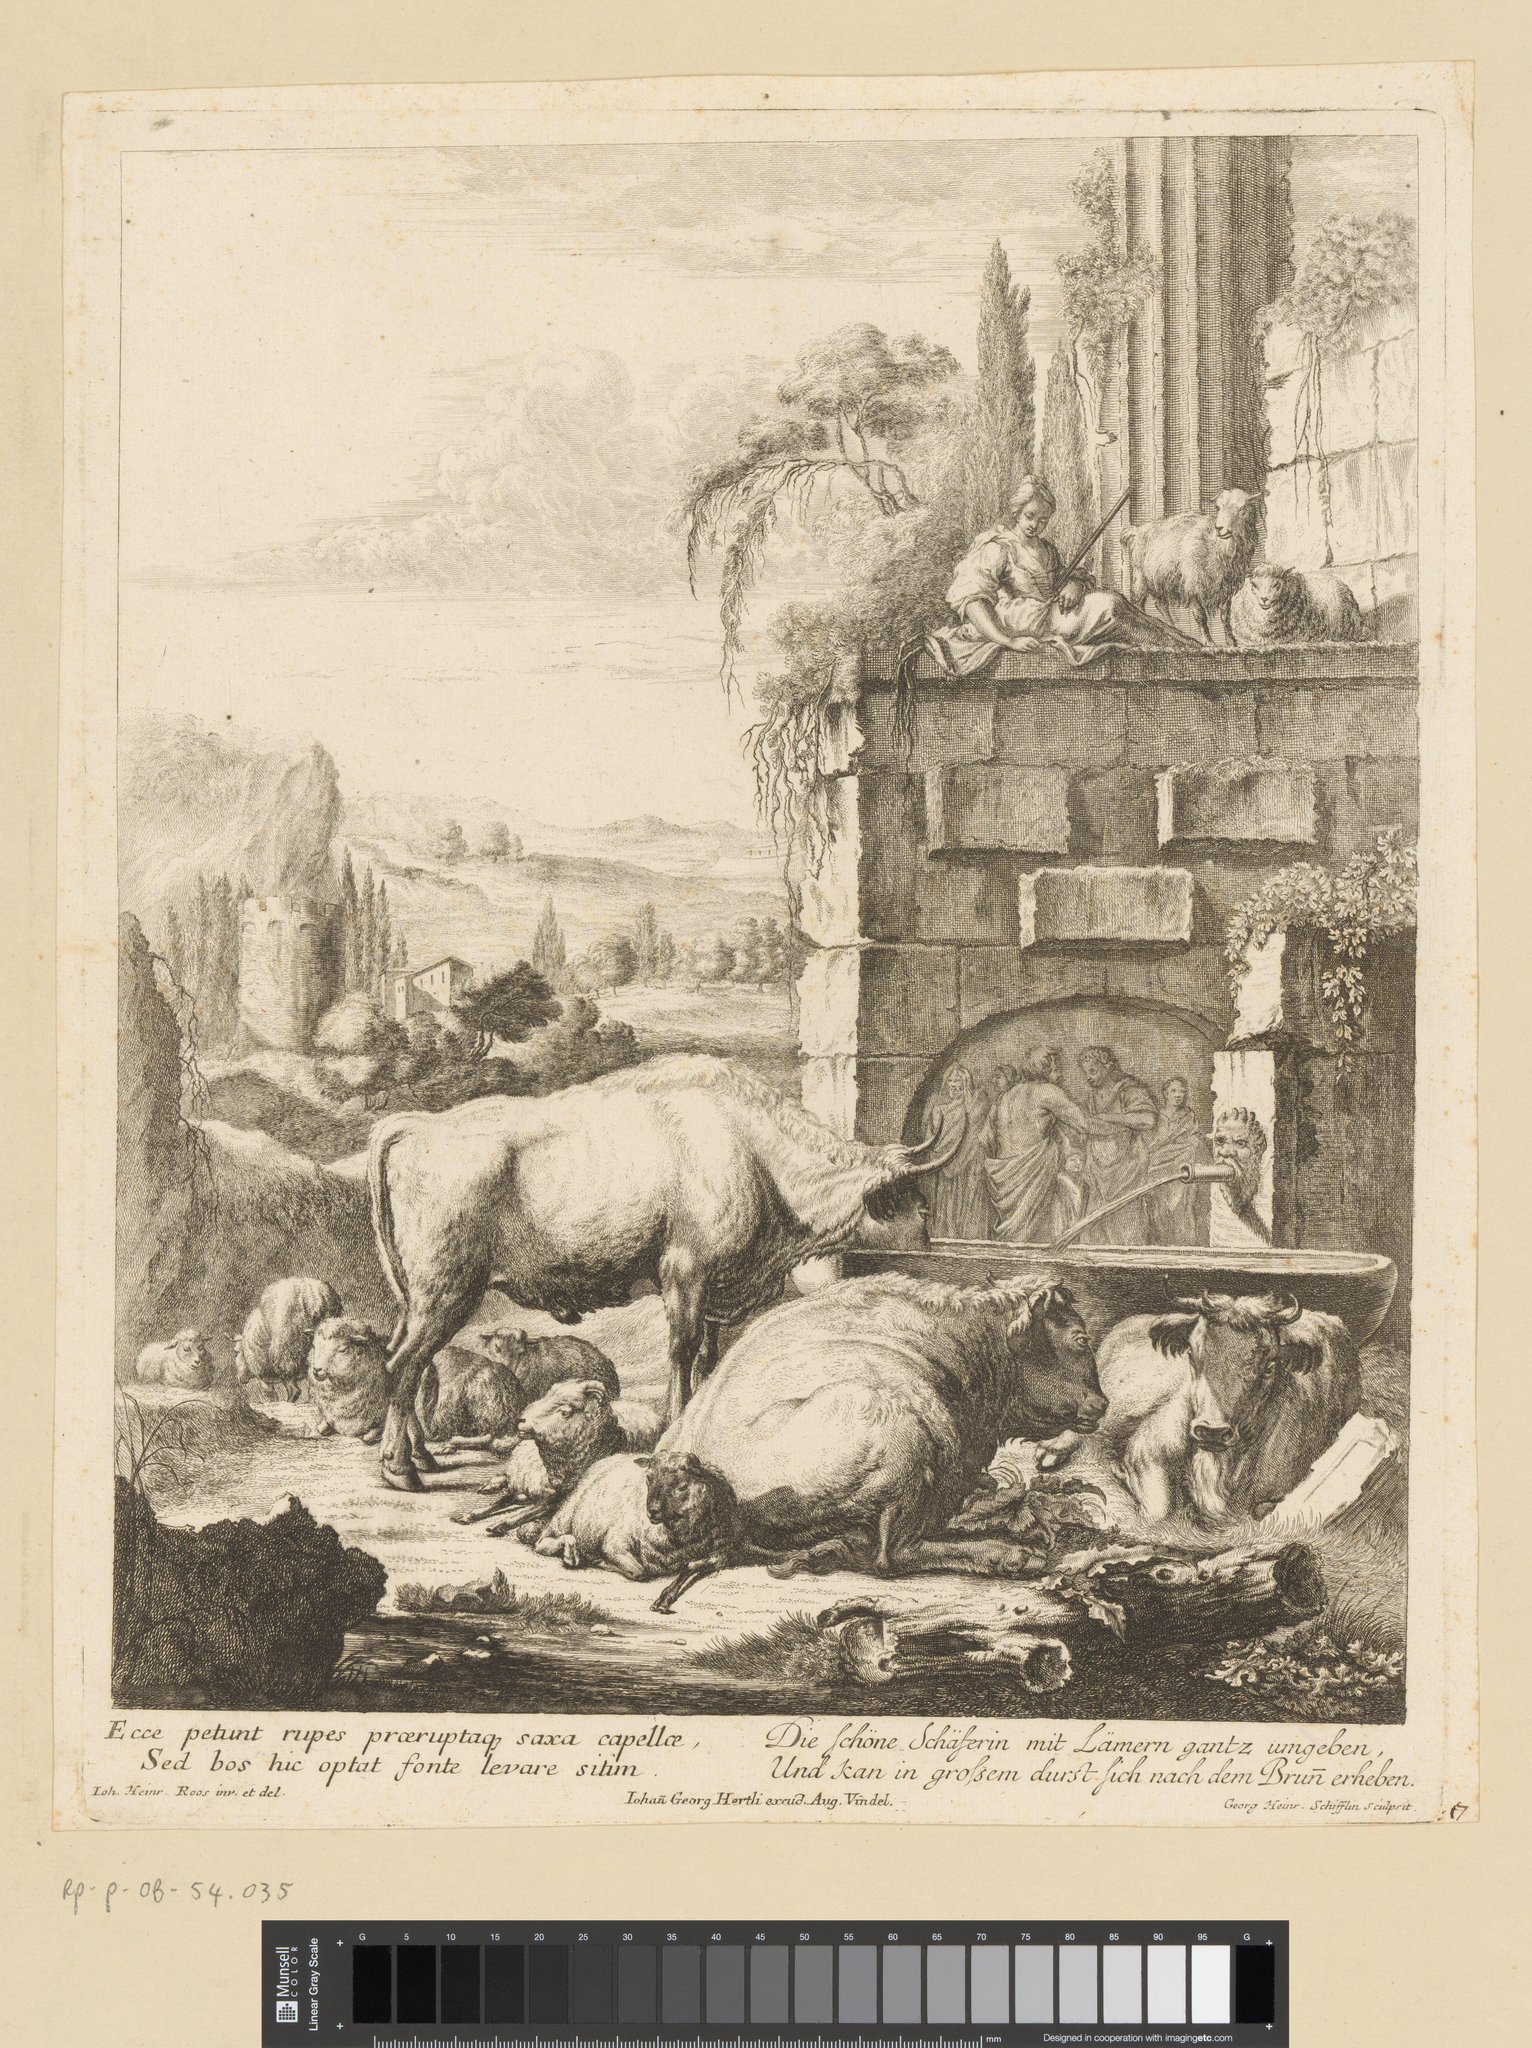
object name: print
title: Antieke bouwwerken met vee naar Roos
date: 1666-1745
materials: paper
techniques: etching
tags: herding, herdsman, herdswoman, shepherd, shepherdess, cowherd, etc., cattle, landscape with ruins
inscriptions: collector's mark: Lugt 240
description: Onderdeel van een serie van vier prenten met landschappen met antieke bouwwerken met vee naar Johann Heinrich Roos.